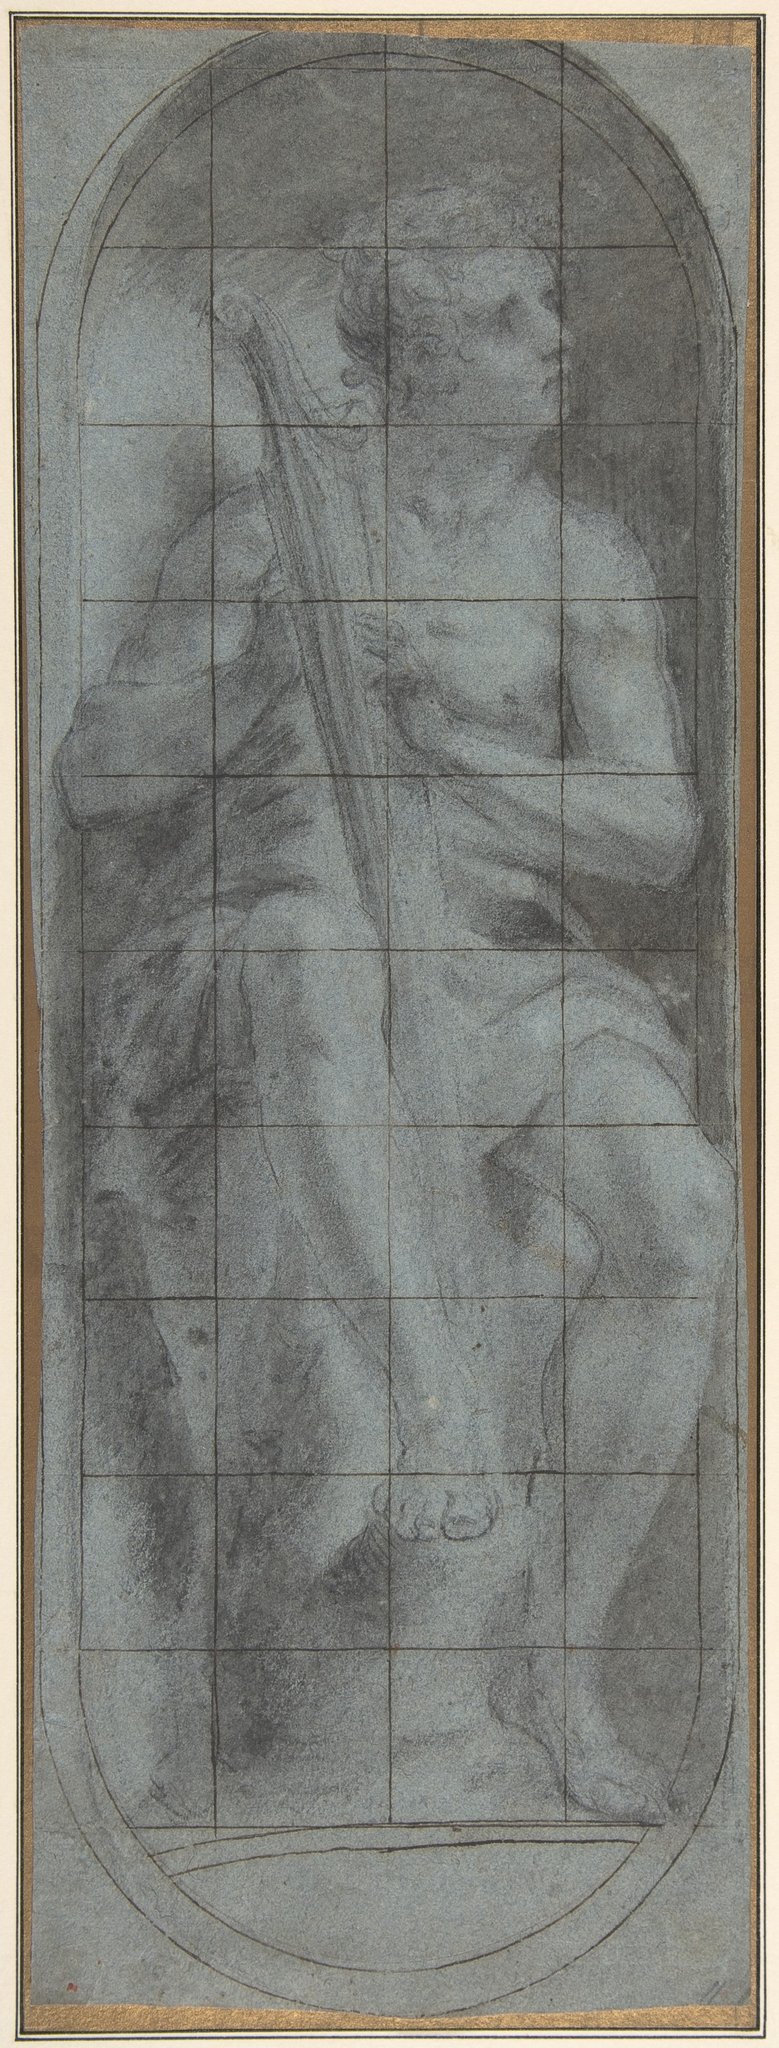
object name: drawing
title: The Young David Playing the Harp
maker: michelangelo anselmi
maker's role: artist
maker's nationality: italian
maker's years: 1492-1556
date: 1548-1550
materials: chalk, ink, paper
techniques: brush, pen, drawing, wash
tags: harps,david